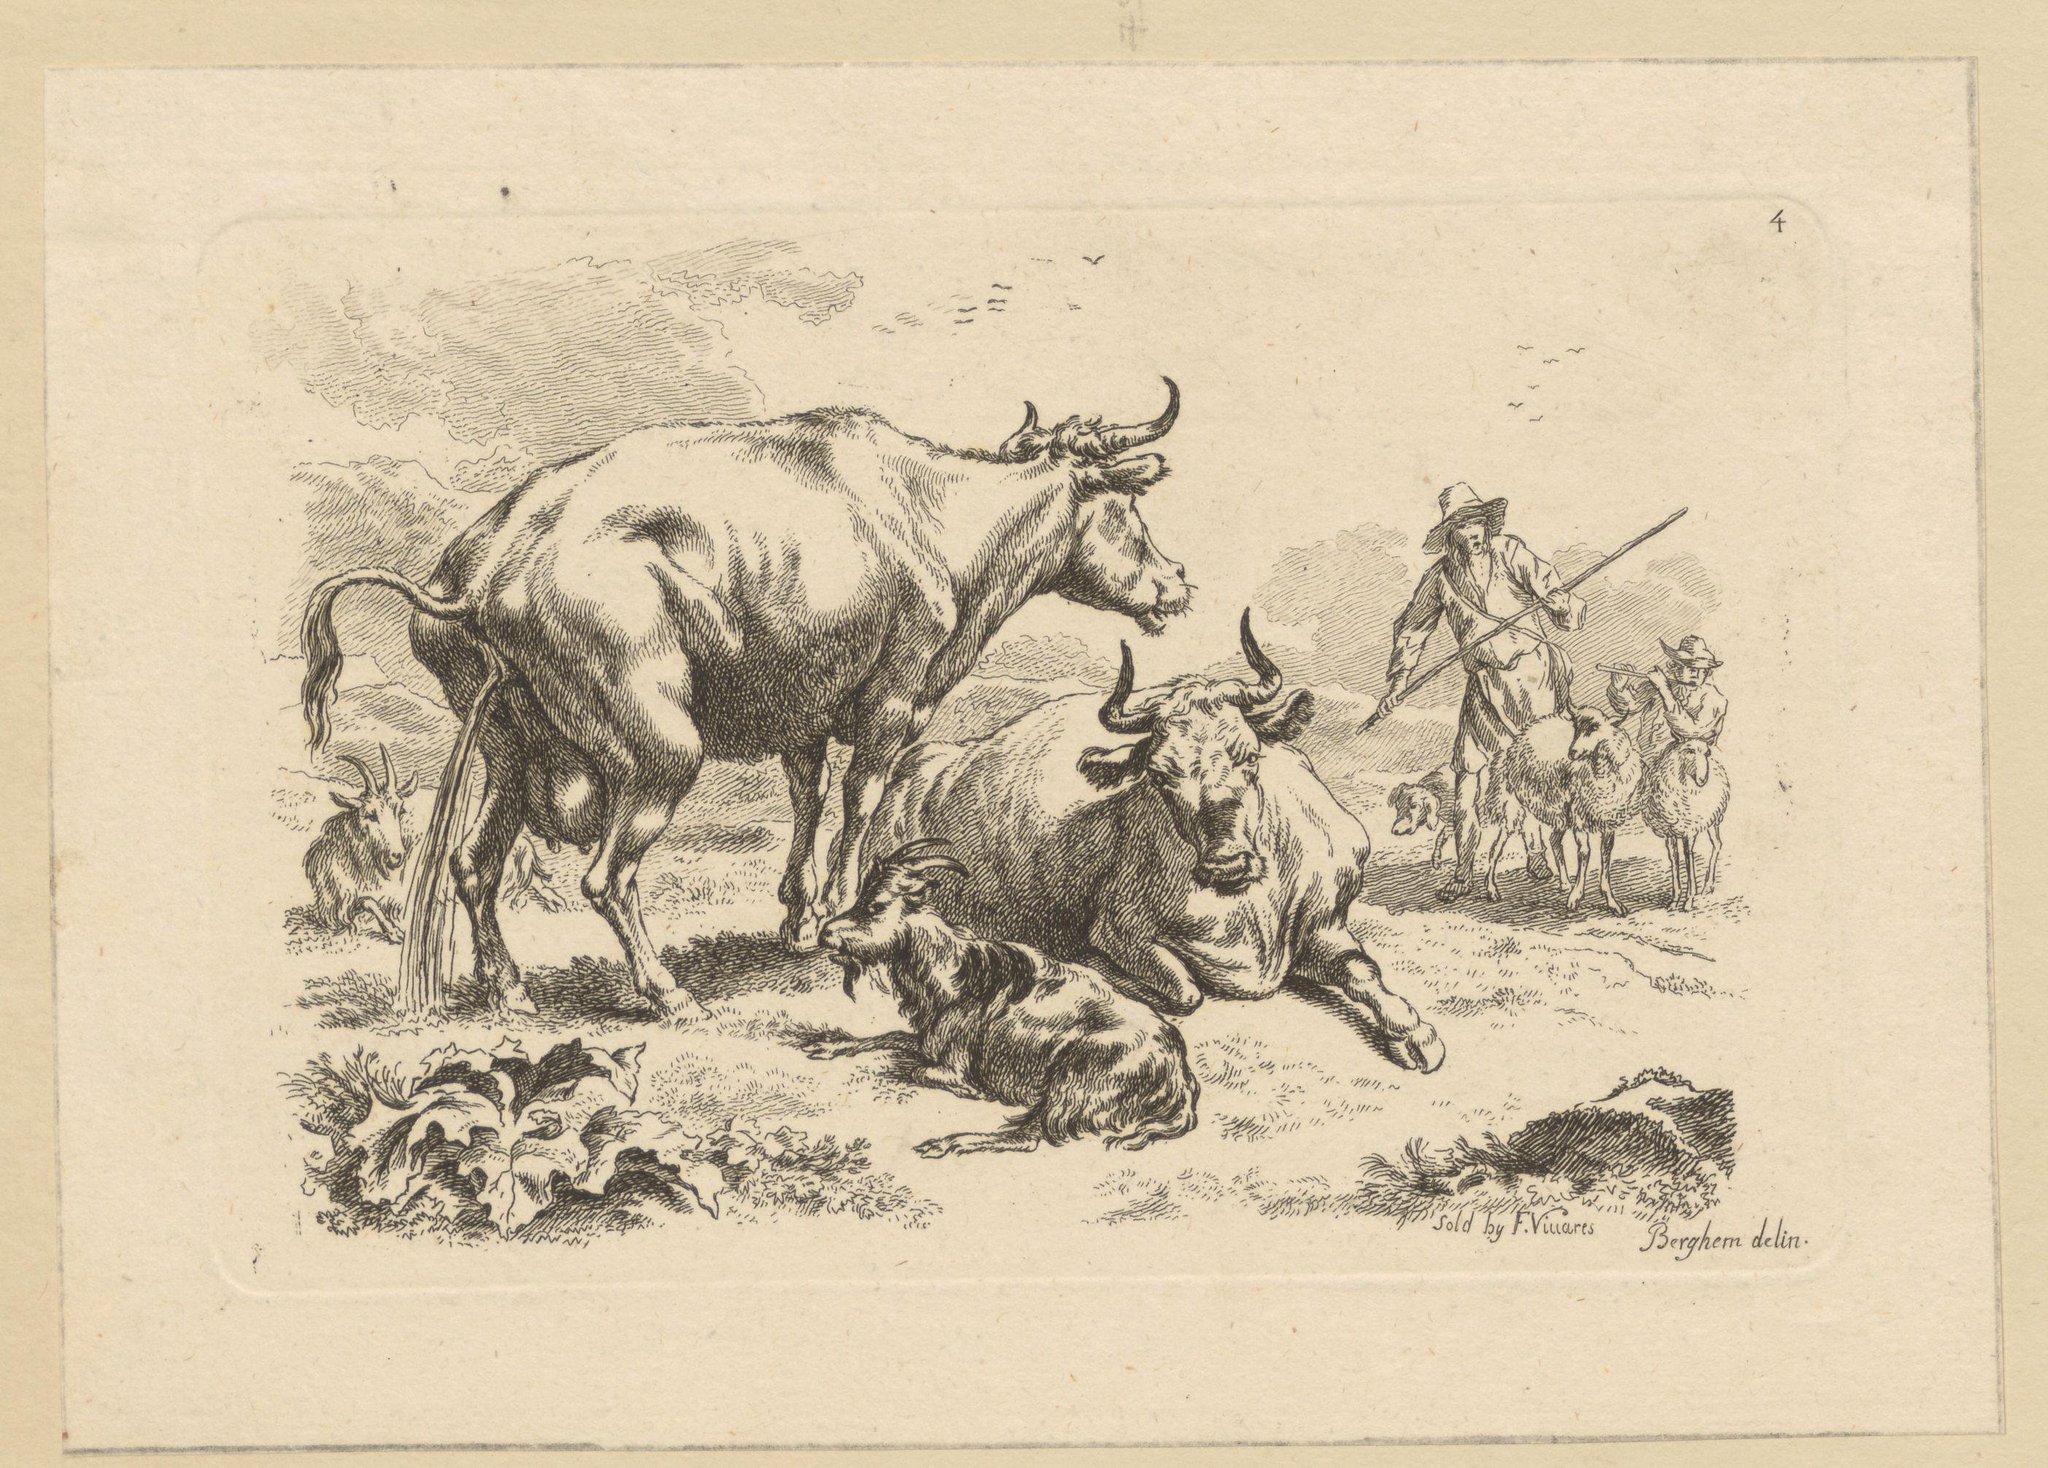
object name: print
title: Herders met vee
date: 1719-1780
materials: paper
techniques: etching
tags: cow, herding, herdsman, herdswoman, shepherd, shepherdess, cowherd, etc., goat, urination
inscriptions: collector's mark: Lugt 240